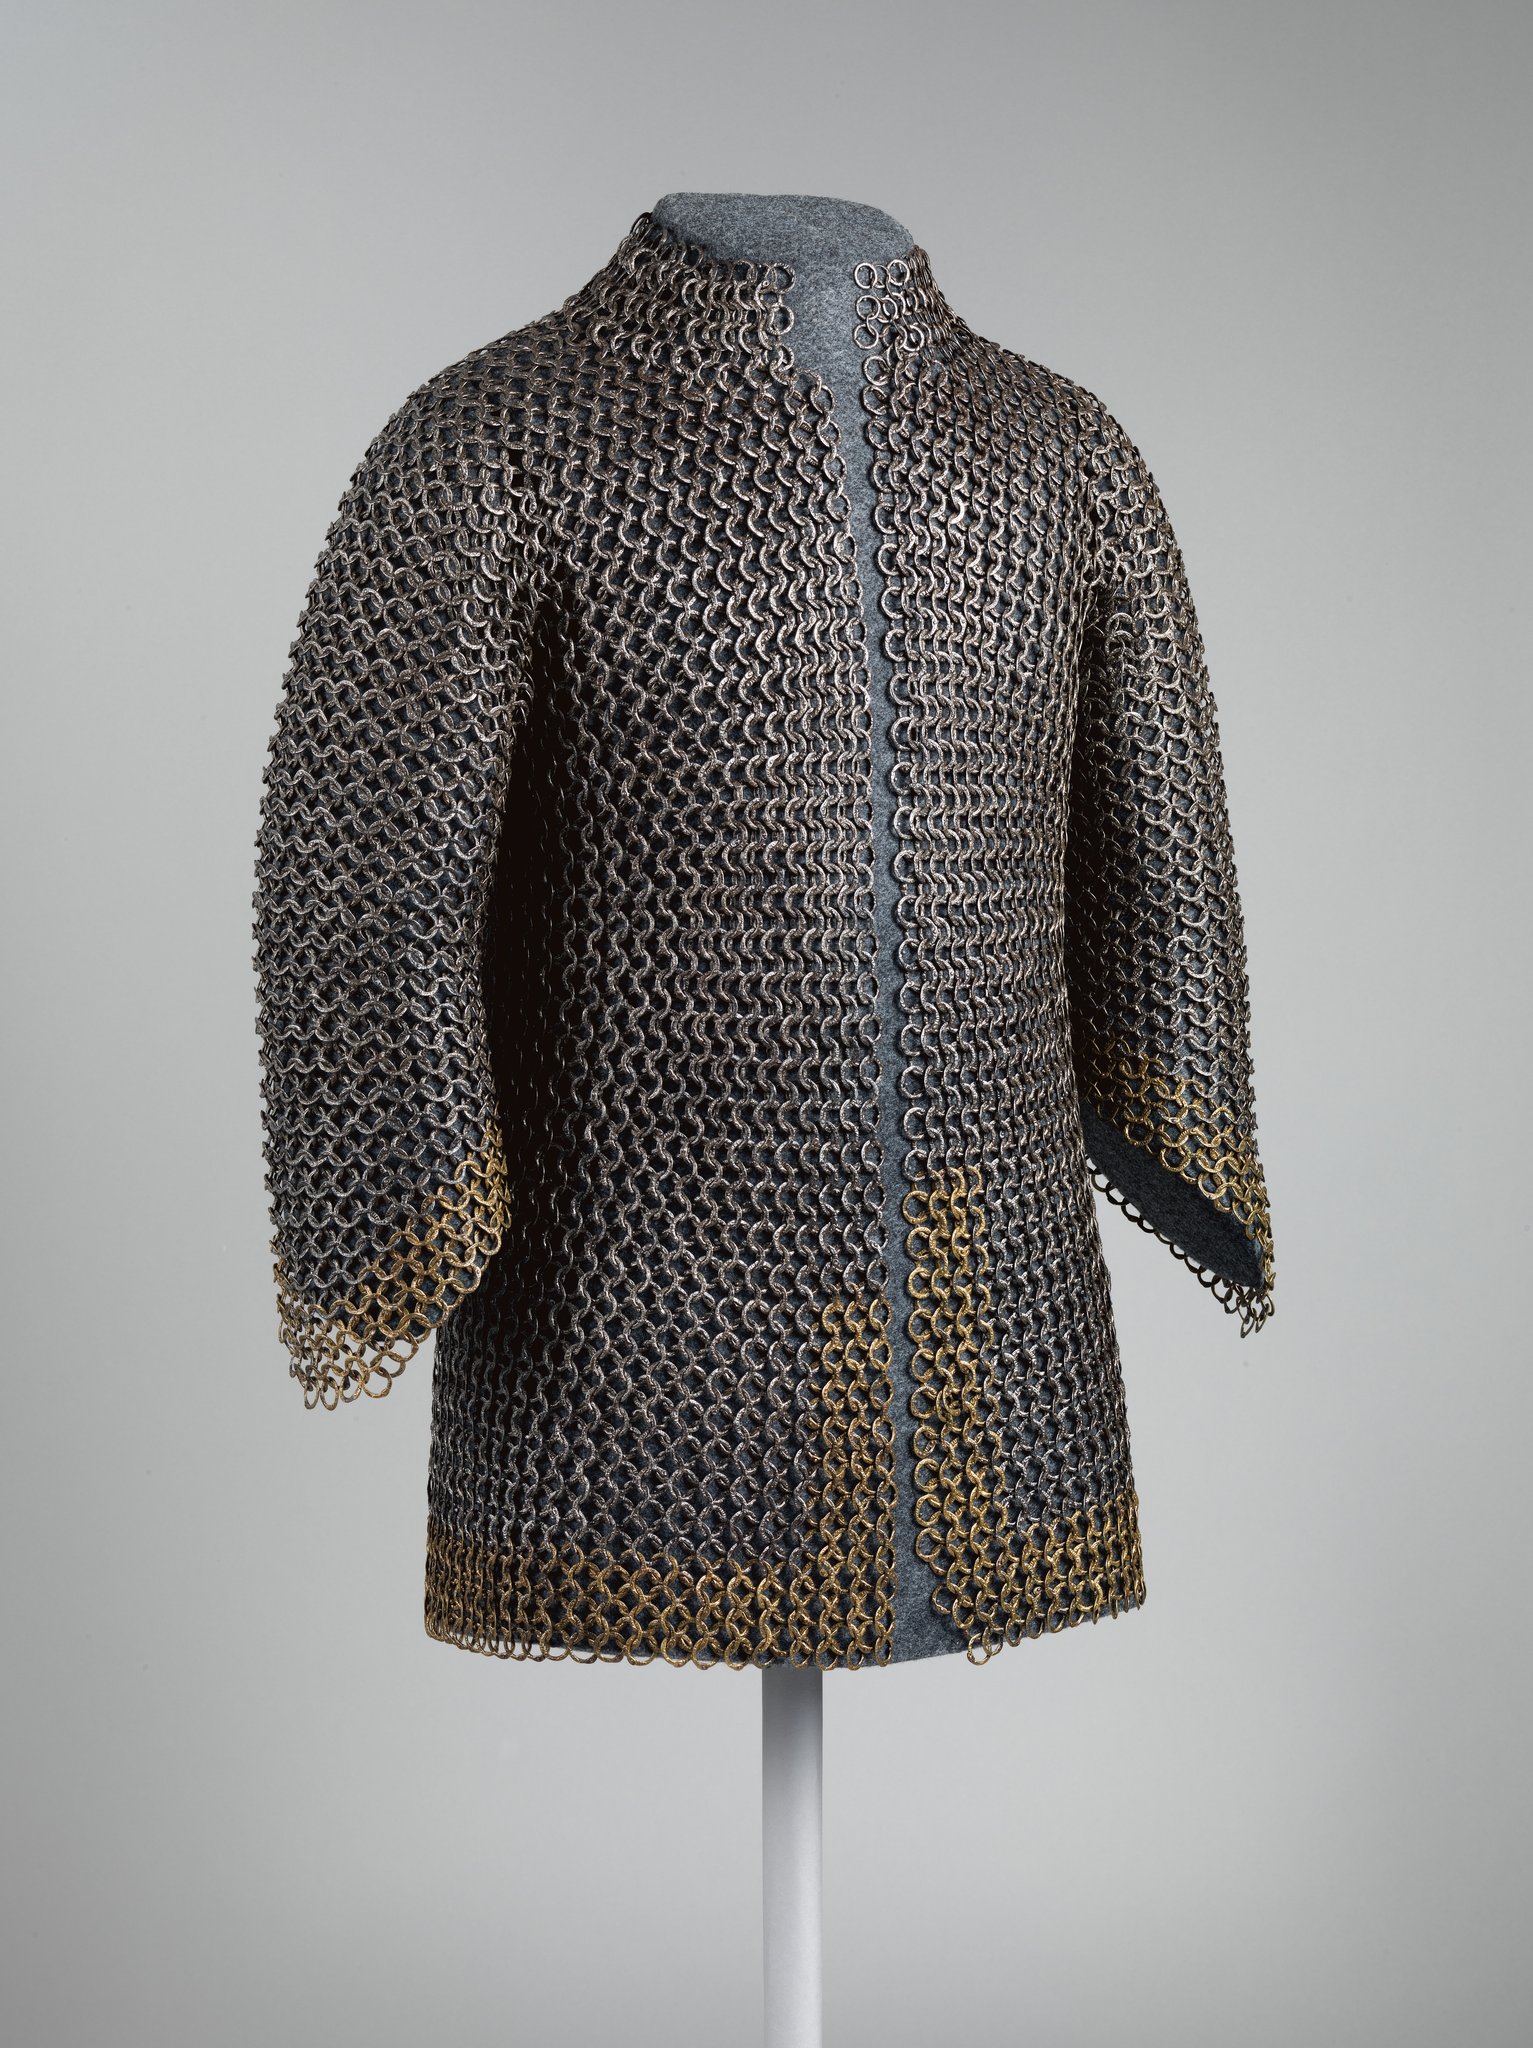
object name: mail shirt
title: Mail Shirt with Inscribed Rings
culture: iranian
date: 1401-1600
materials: copper alloy, iron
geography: iran